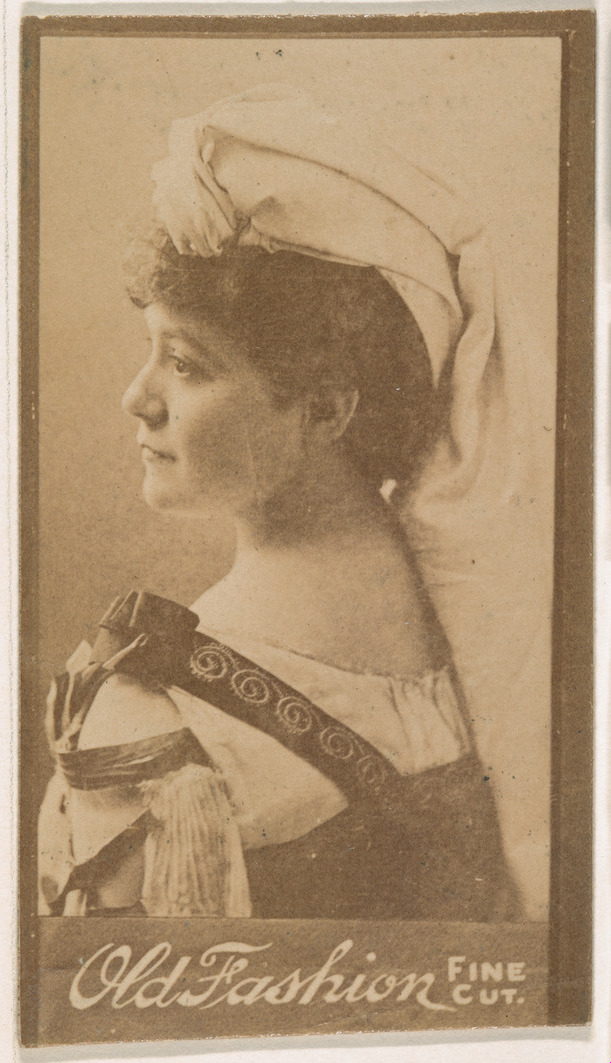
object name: photograph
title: Portrait wearing cloth turban, from the Actresses series (N664) promoting Old Fashion Fine Cut Tobacco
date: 1888-1890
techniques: albumen silver print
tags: portraits,women,actresses